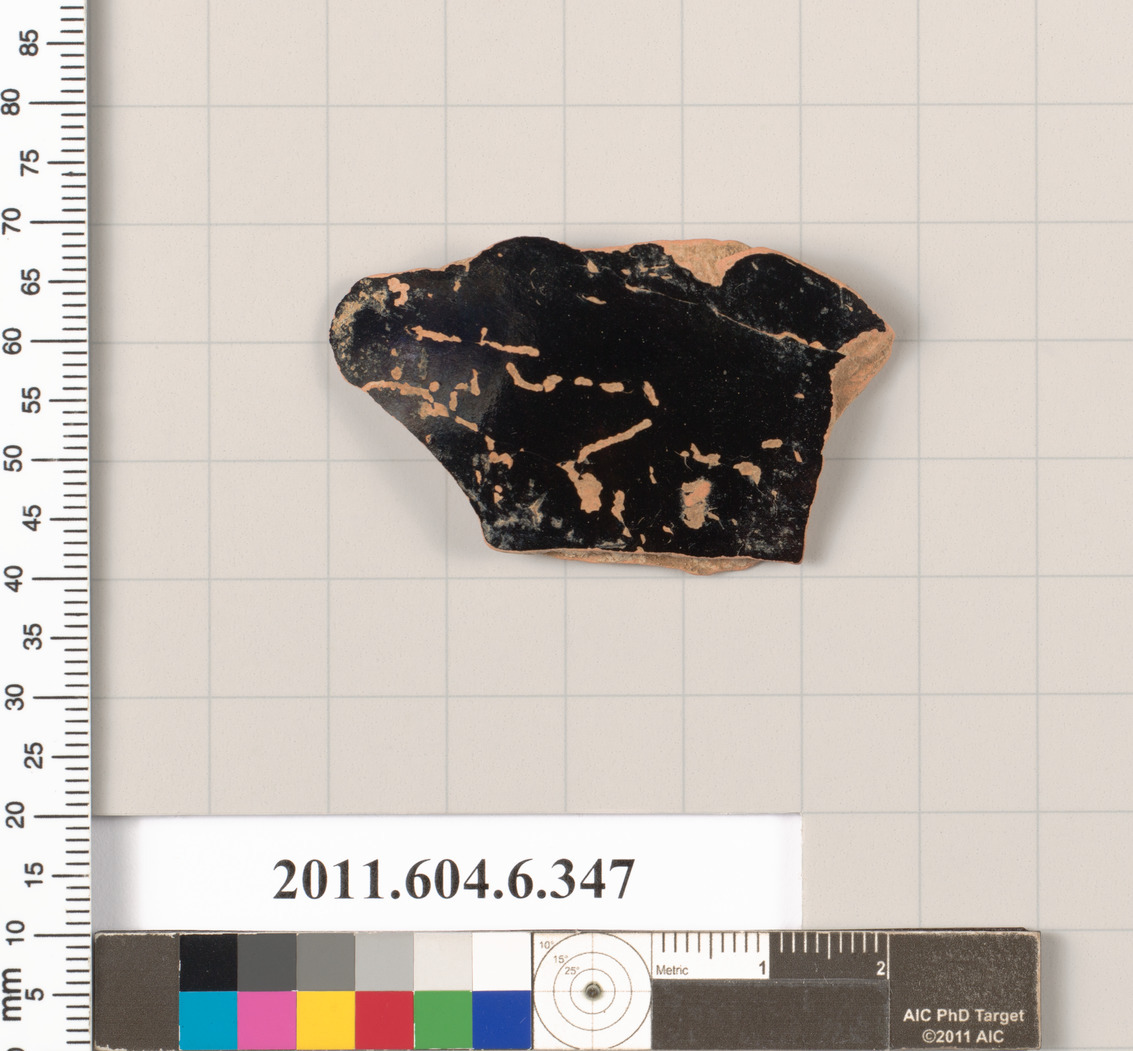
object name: undetermined closed shape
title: Terracotta fragment of a closed shape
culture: greek, attic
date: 600-401 BCE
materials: terracotta